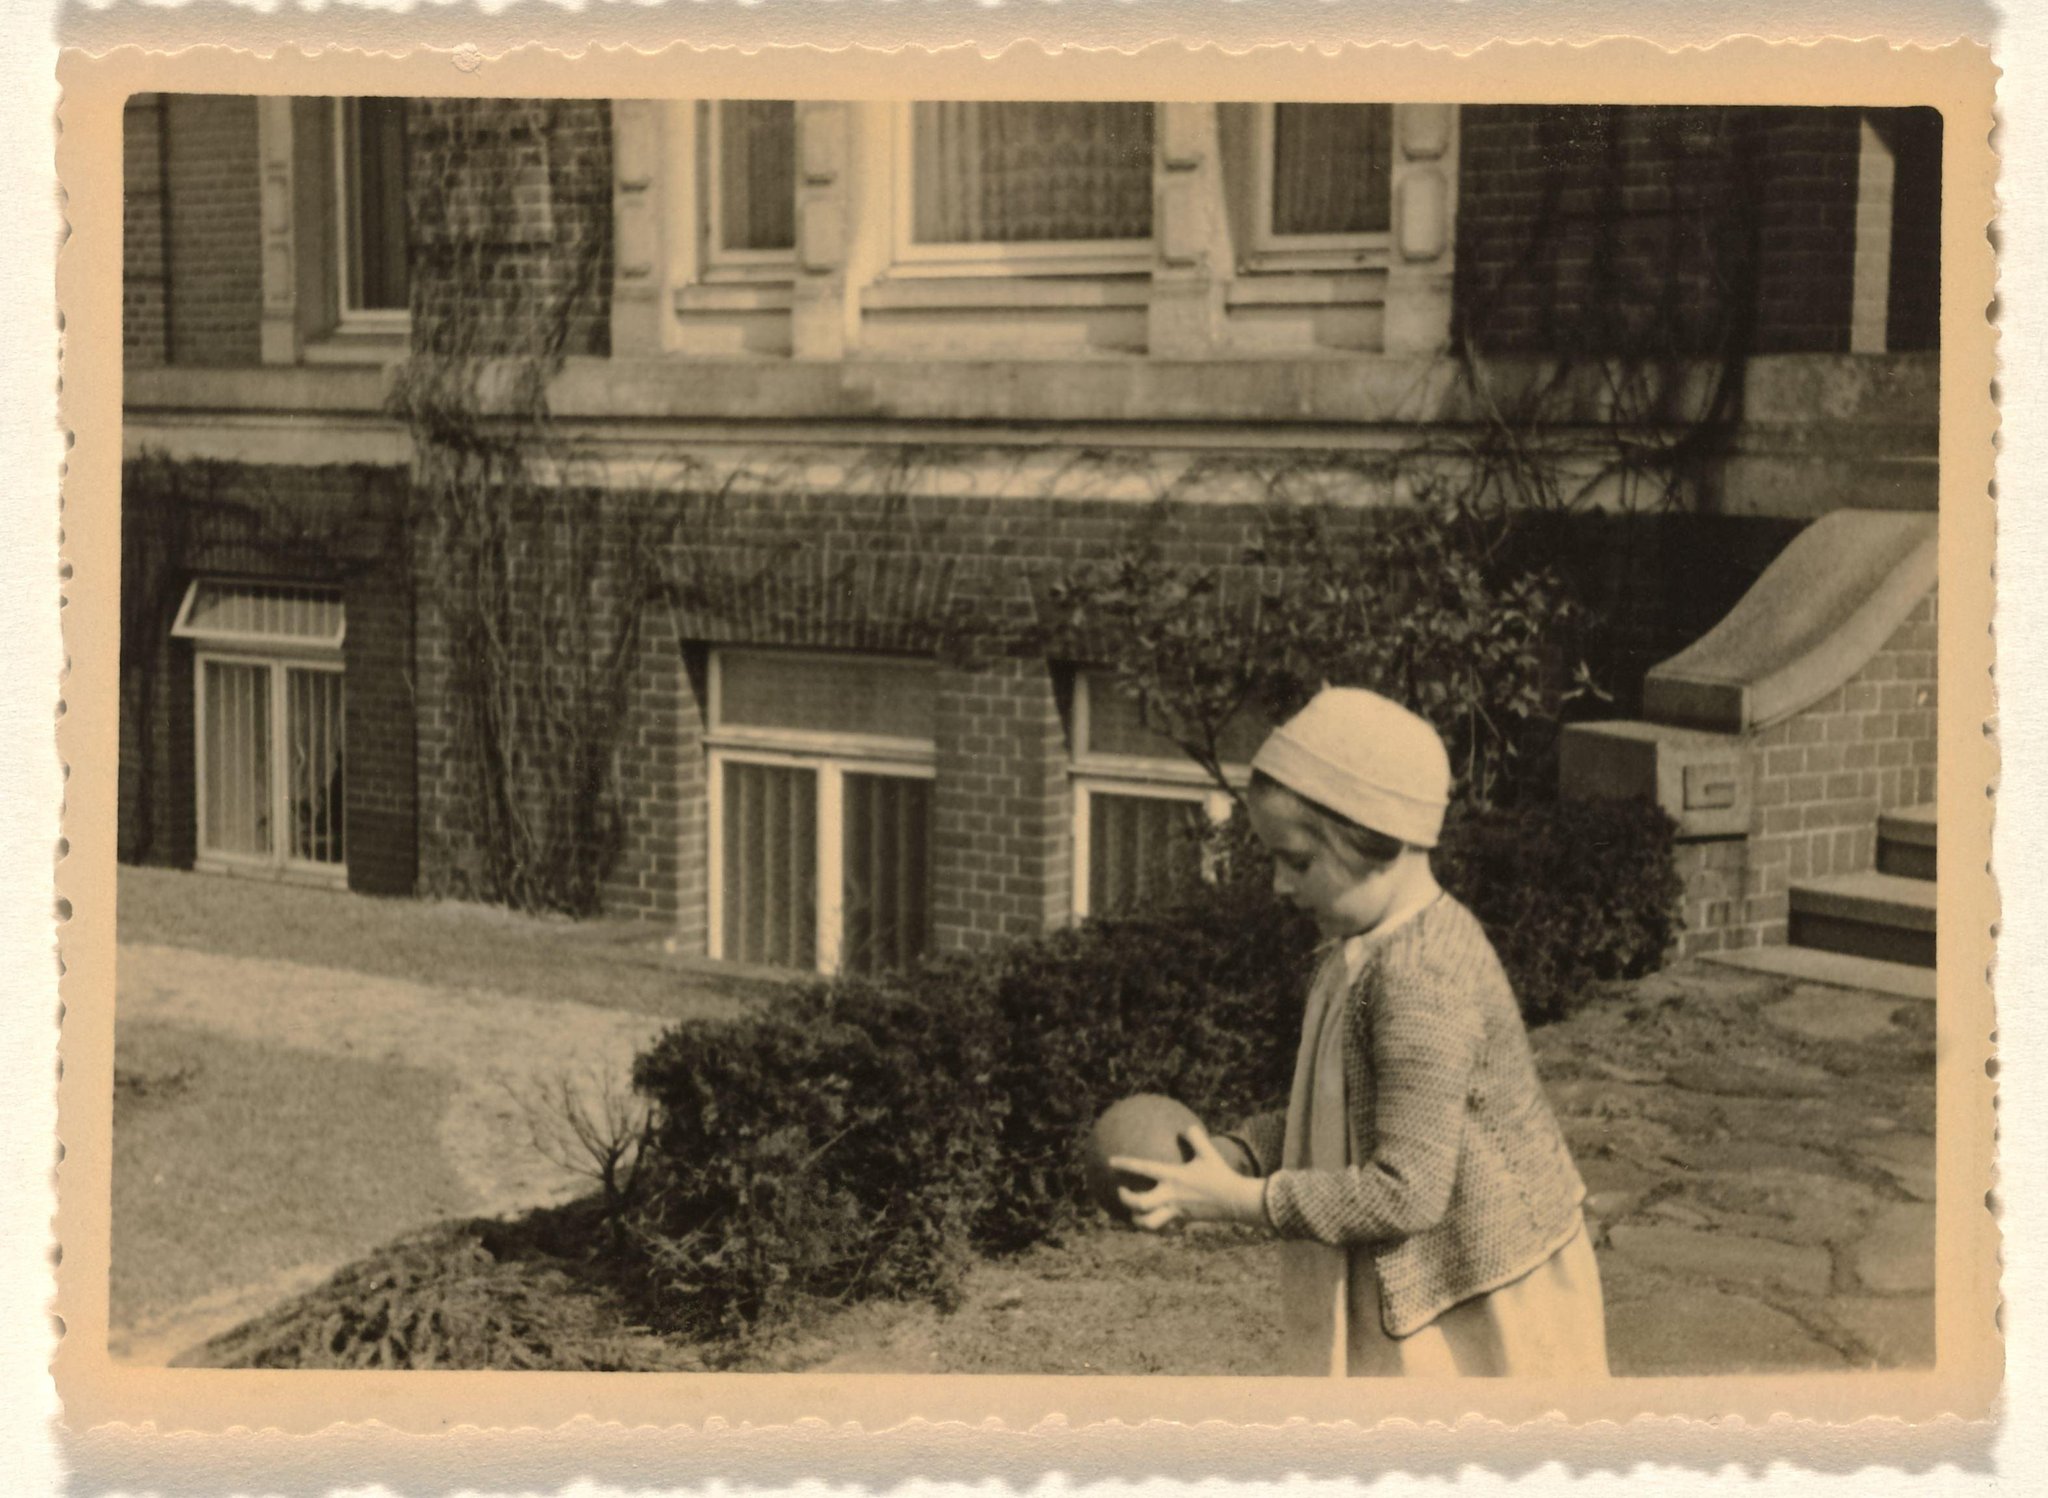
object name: photograph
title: Isabel Wachenheimer voor het huis van haar oom Willy Moos, Bellevue 62 in Hamburg, in 1935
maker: Anonymous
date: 1935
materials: photographic support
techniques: gelatin silver print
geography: hamburg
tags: leiden, isabel wachenheimer-elon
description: Dit object is onderdeel van de nalatenschap van Isabel Elon-Wachenheimer (1928-2010). Tot haar overlijden behoorde het samen met de andere objecten uit de nalatenschap tot haar privédomein van Isabel Wachenheimer. In die particuliere context zijn deze objecten tezamen en individueel aandenkens - aan de jeugd, ouders en familie van Isabel Wachenheimer vóór en tijdens de Shoah en aan haar leven na de Tweede Wereldoorlog. Isabel Wachenheimer, die van juni 1943 tot mei 1945 gevangen zat in Kamp Westerbork, Theresienstadt, Auschwitz, Lenzing a/d Oberdonau (een buitenkamp van Mauthausen), overleefde de Shoah. Haar ouders – Eugène Wachenheimer en Else Wachenheimer-Moos - werden op 14 oktober 1944 in Auschwitz-Birkenau vermoord.